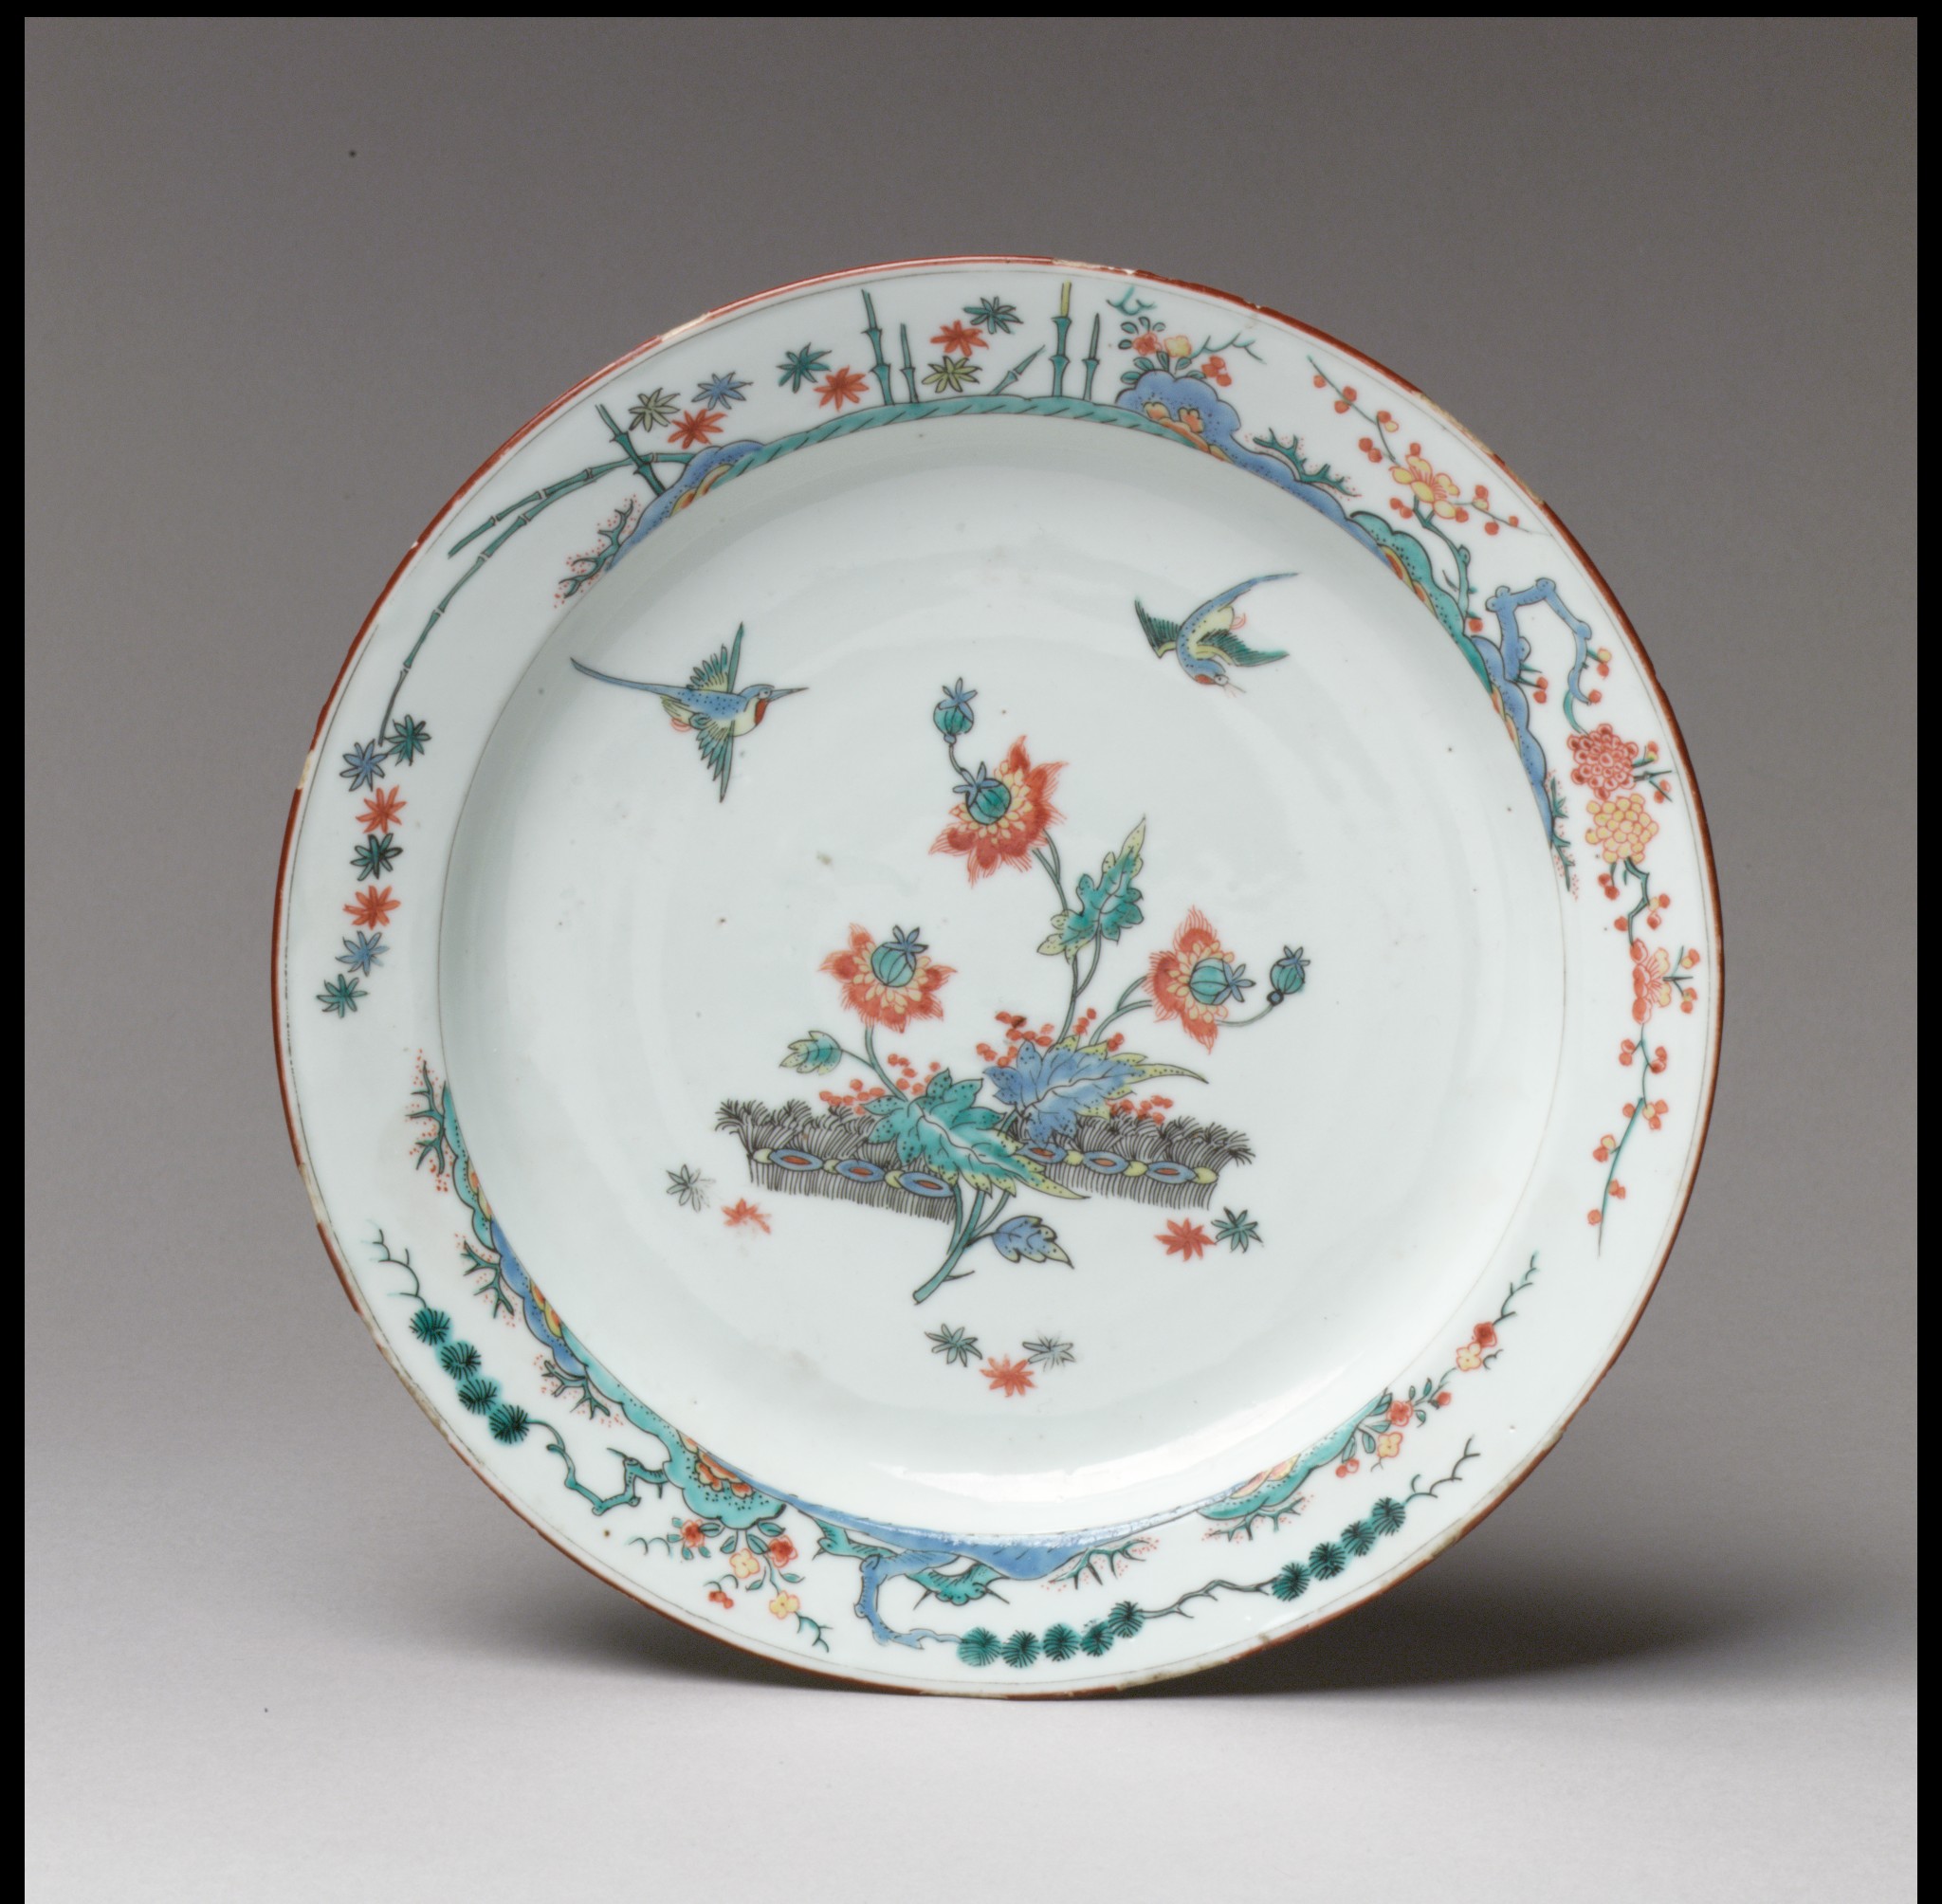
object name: plate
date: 1730-1740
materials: hard paste porcelain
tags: birds,flowers